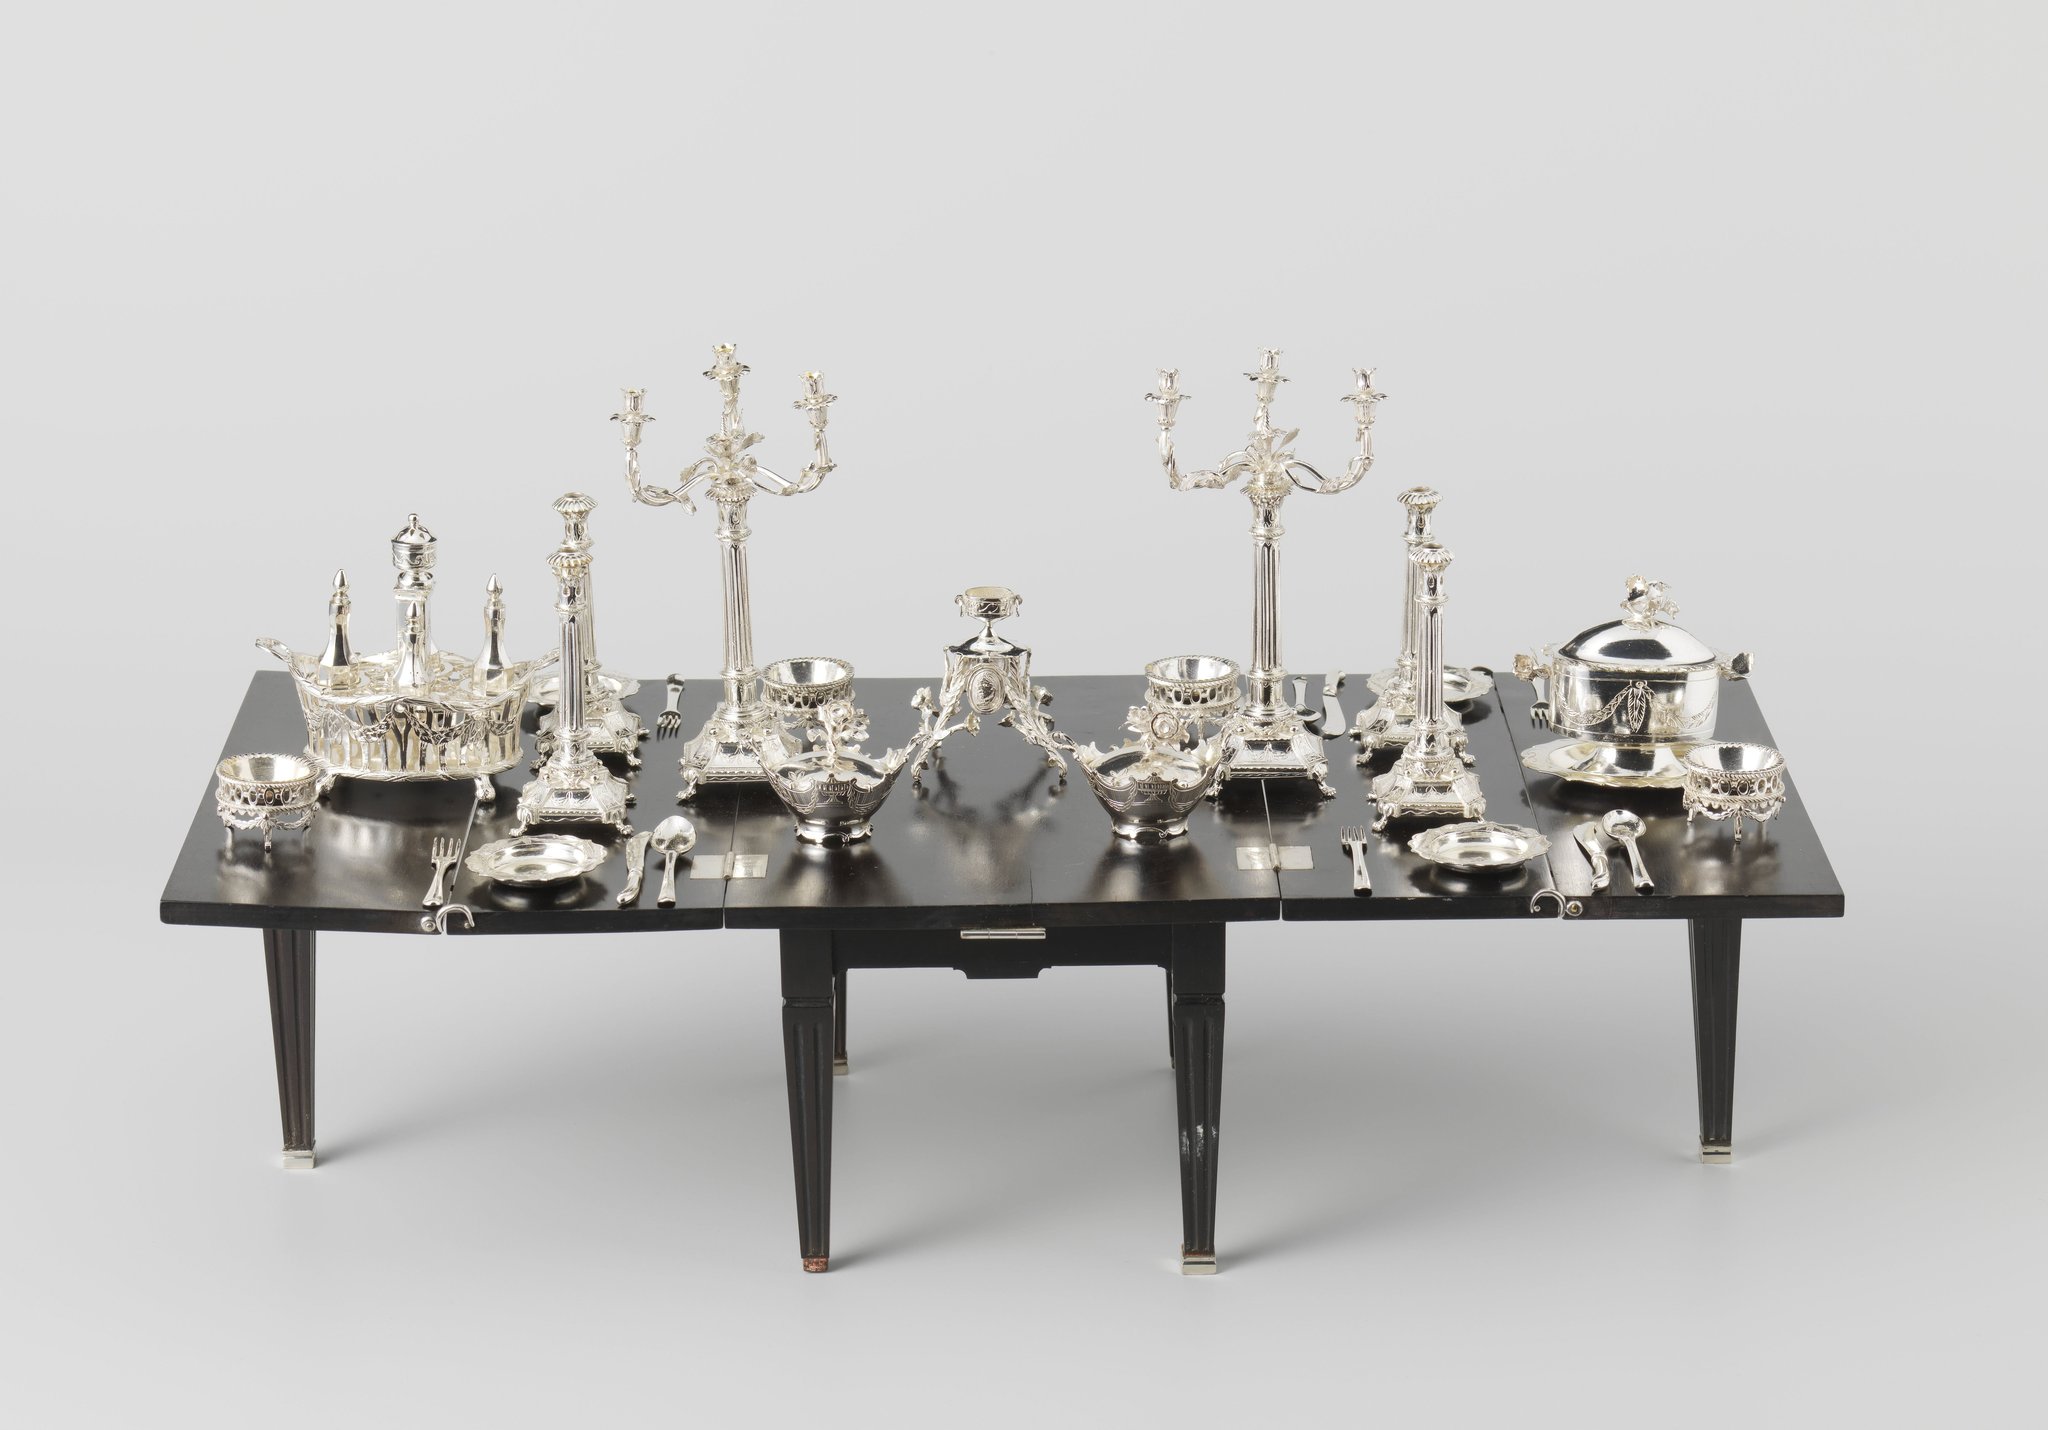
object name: miniature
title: Zoutvat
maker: Anonymous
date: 1775-1800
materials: silver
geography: amsterdam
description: Zoutvat op drie poten. Tussen de poten hangen guirlandes. Boven de guirlandes is een opengewerkte galerij met ovalen. De losse binnenbak heeft een parelrand. Het zoutvat is niet gemerkt.